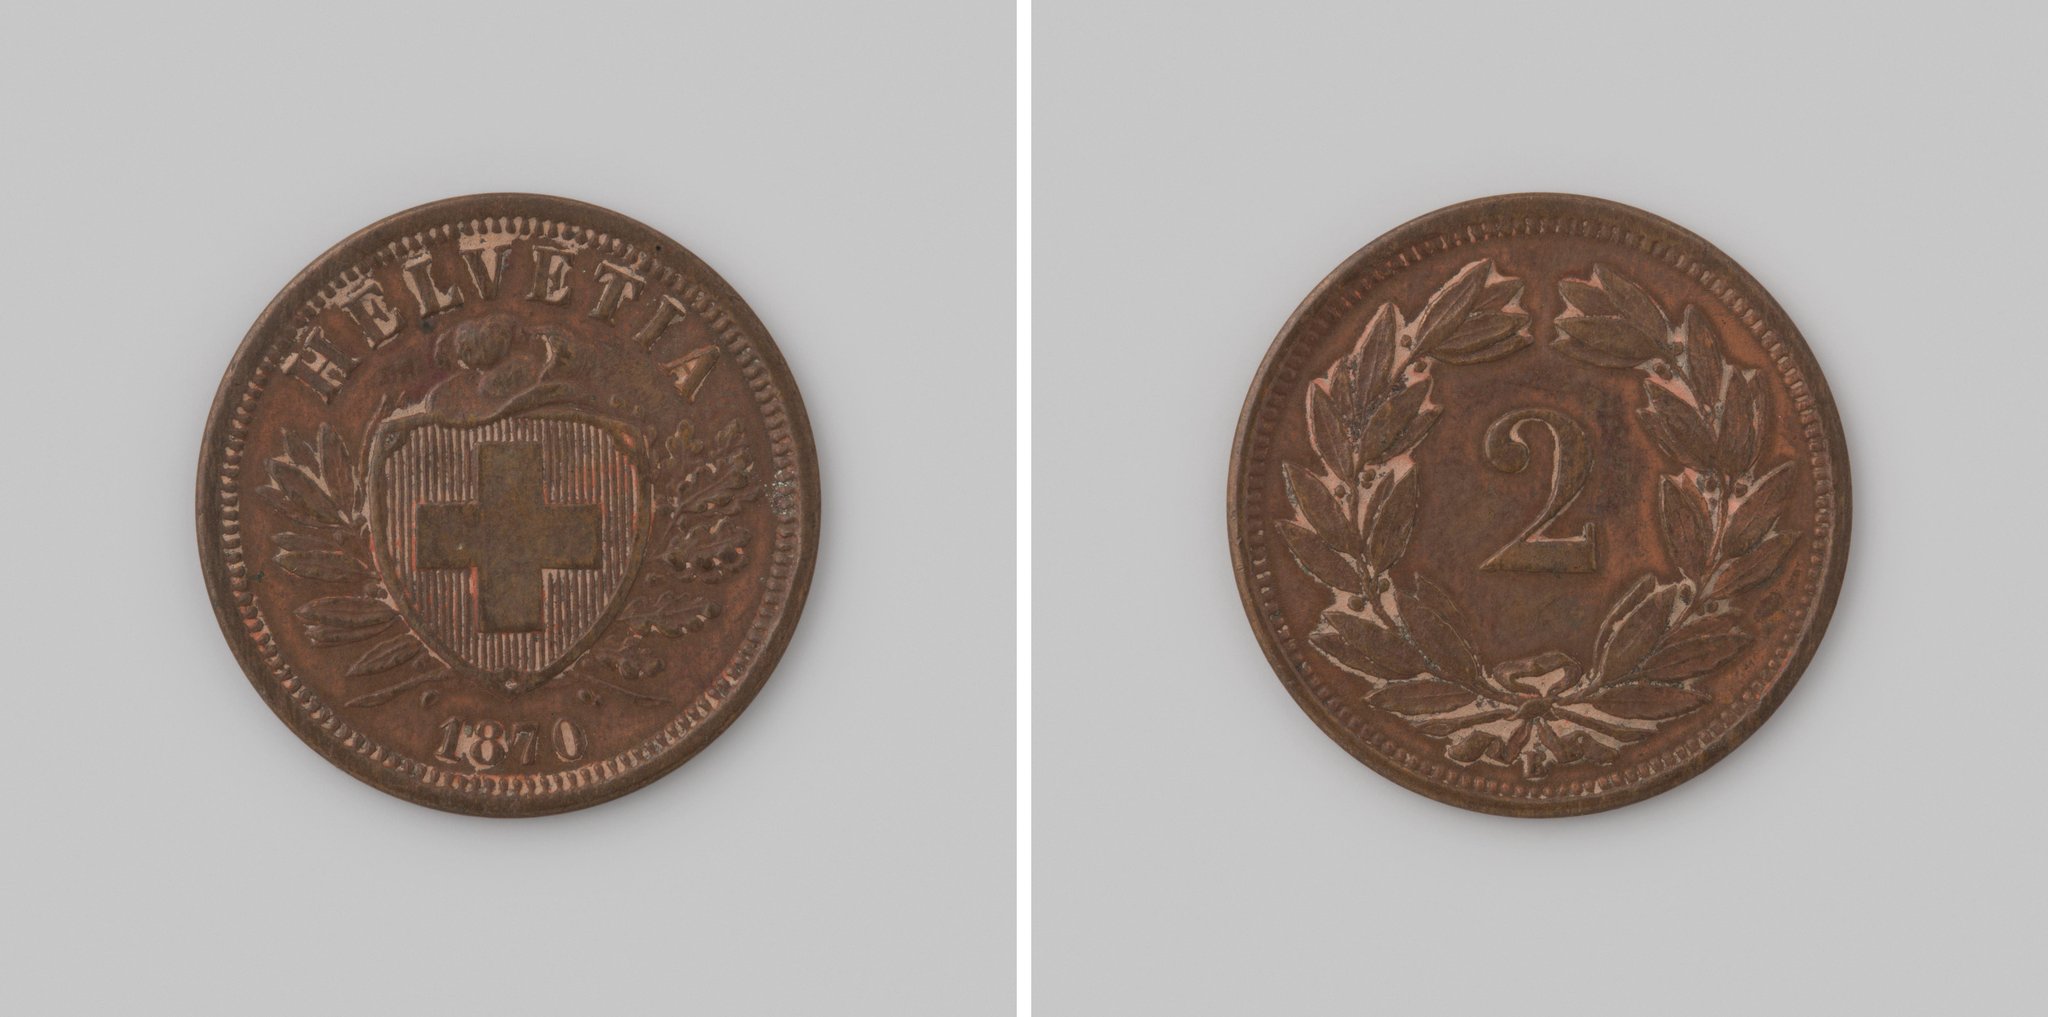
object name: coin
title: Zwitserland, 2 centimes,1870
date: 1870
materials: bronze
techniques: striking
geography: bern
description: Bronzen munt. Voorzijde: het wapenschild van Zwitserland, waarboven vrijheidshoed tegen een achtergrond van laurier- en eikentakken. Jaartal onderaan. Keerzijde: binnen twee samengebonden takken in een regel waarde-aanduiding. Onderaan letter B [=Bern]. Gladde rand.